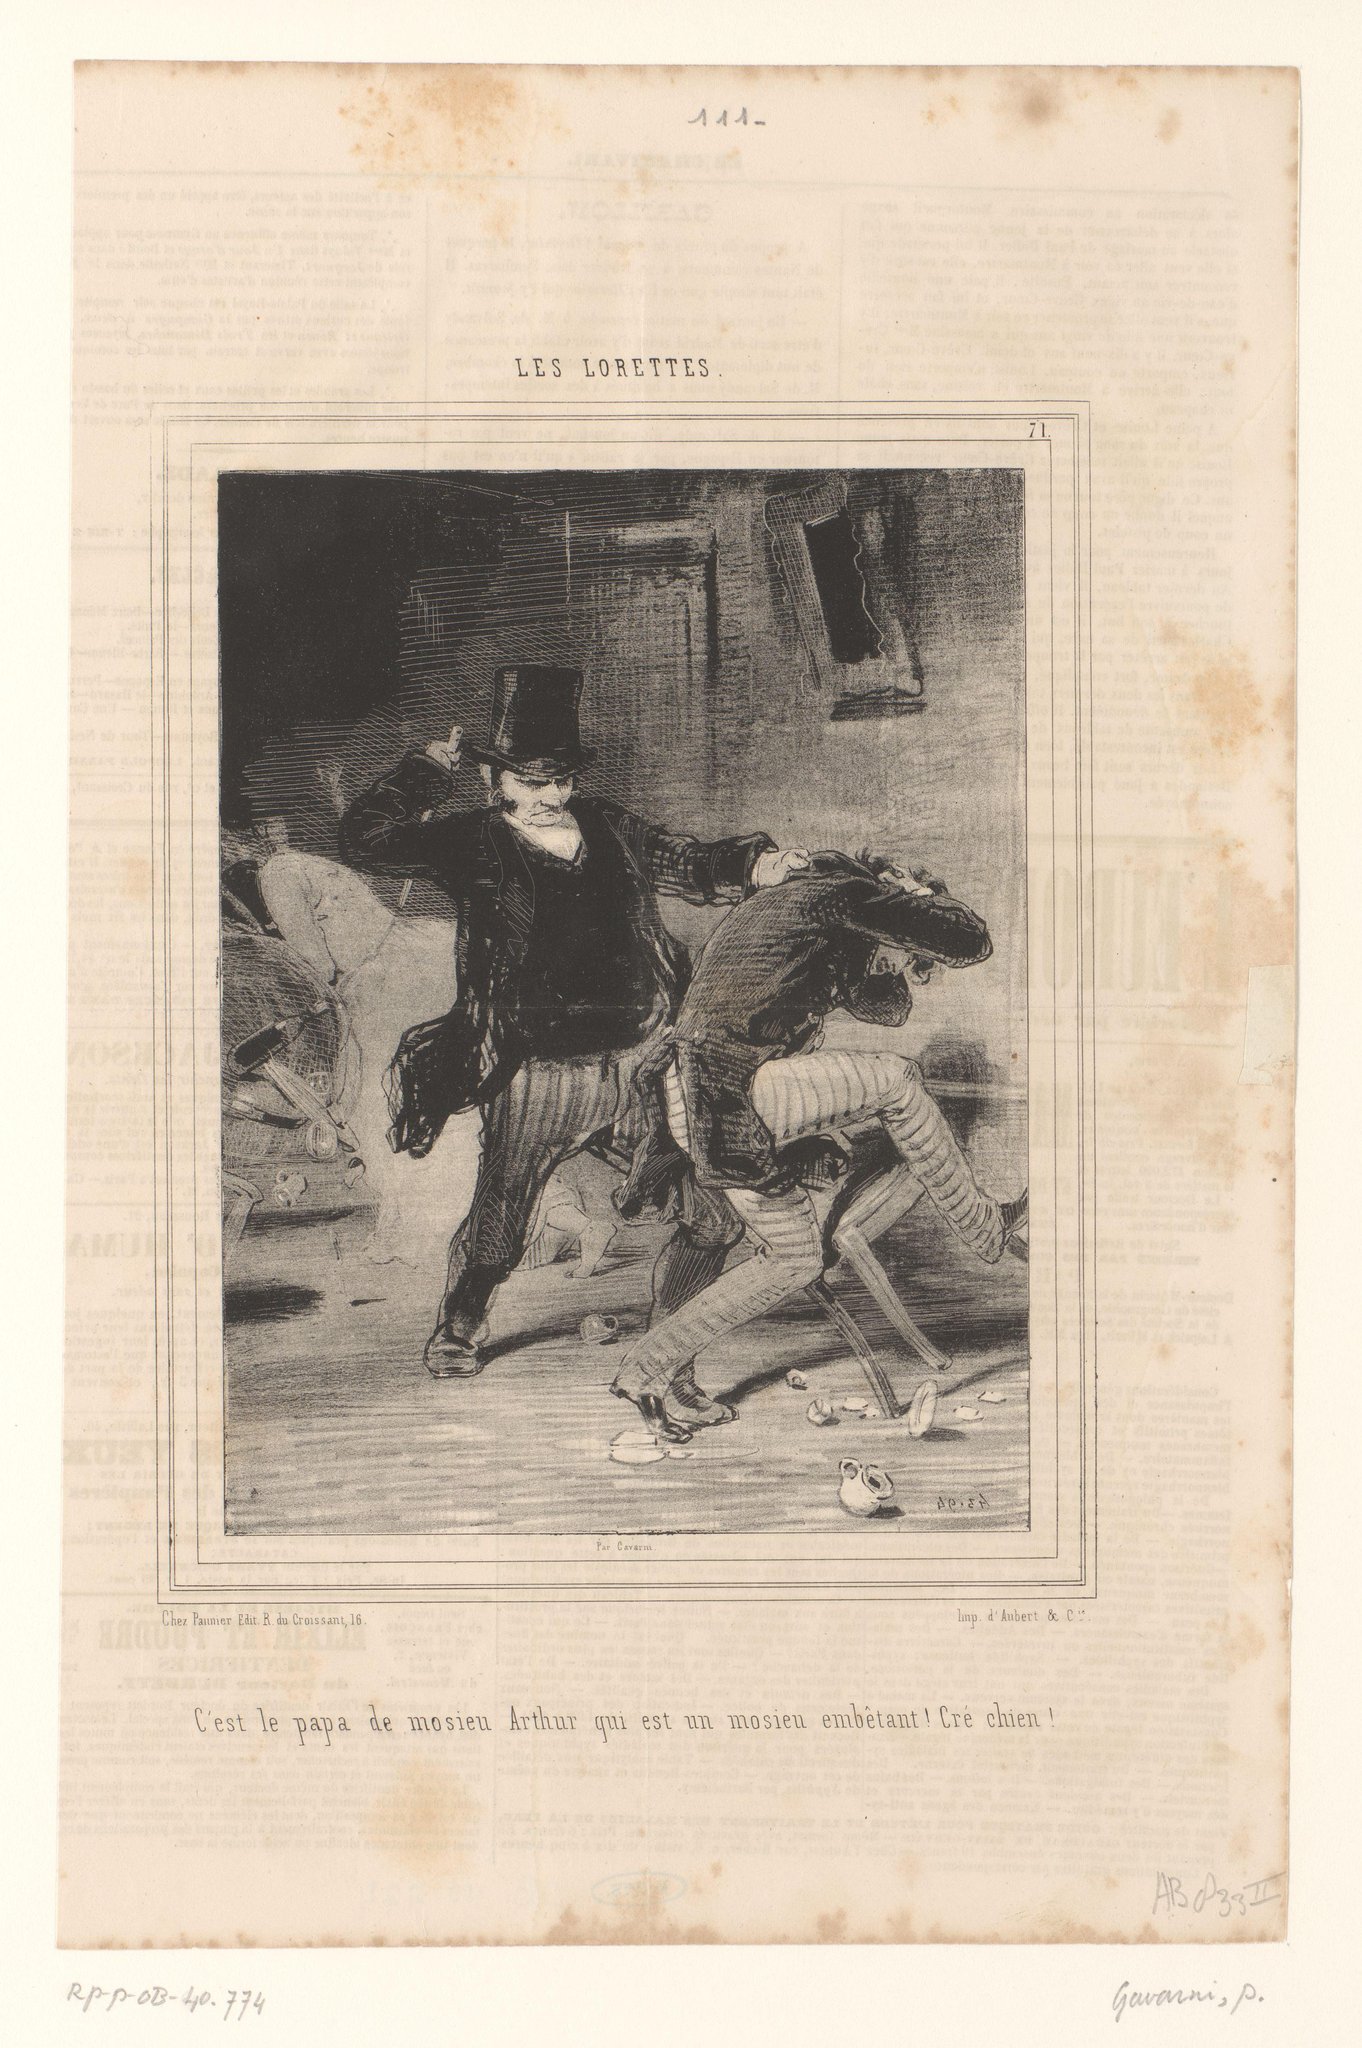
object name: cartoon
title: Vader gaat zijn zoon te lijf met een stok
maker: paul gavarni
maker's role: draughtsman, print maker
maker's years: 1804-1866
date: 1843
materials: paper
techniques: lithograph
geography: paris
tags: flogging, scourging (in public), interrupted meeting, lovers caught by surprise, father and son(s) (family group) (with number of sons), hidden love discovered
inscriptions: collector's mark: Lugt 2228a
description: Prent gebruikt voor: Le Charivari, 29 september 1843.